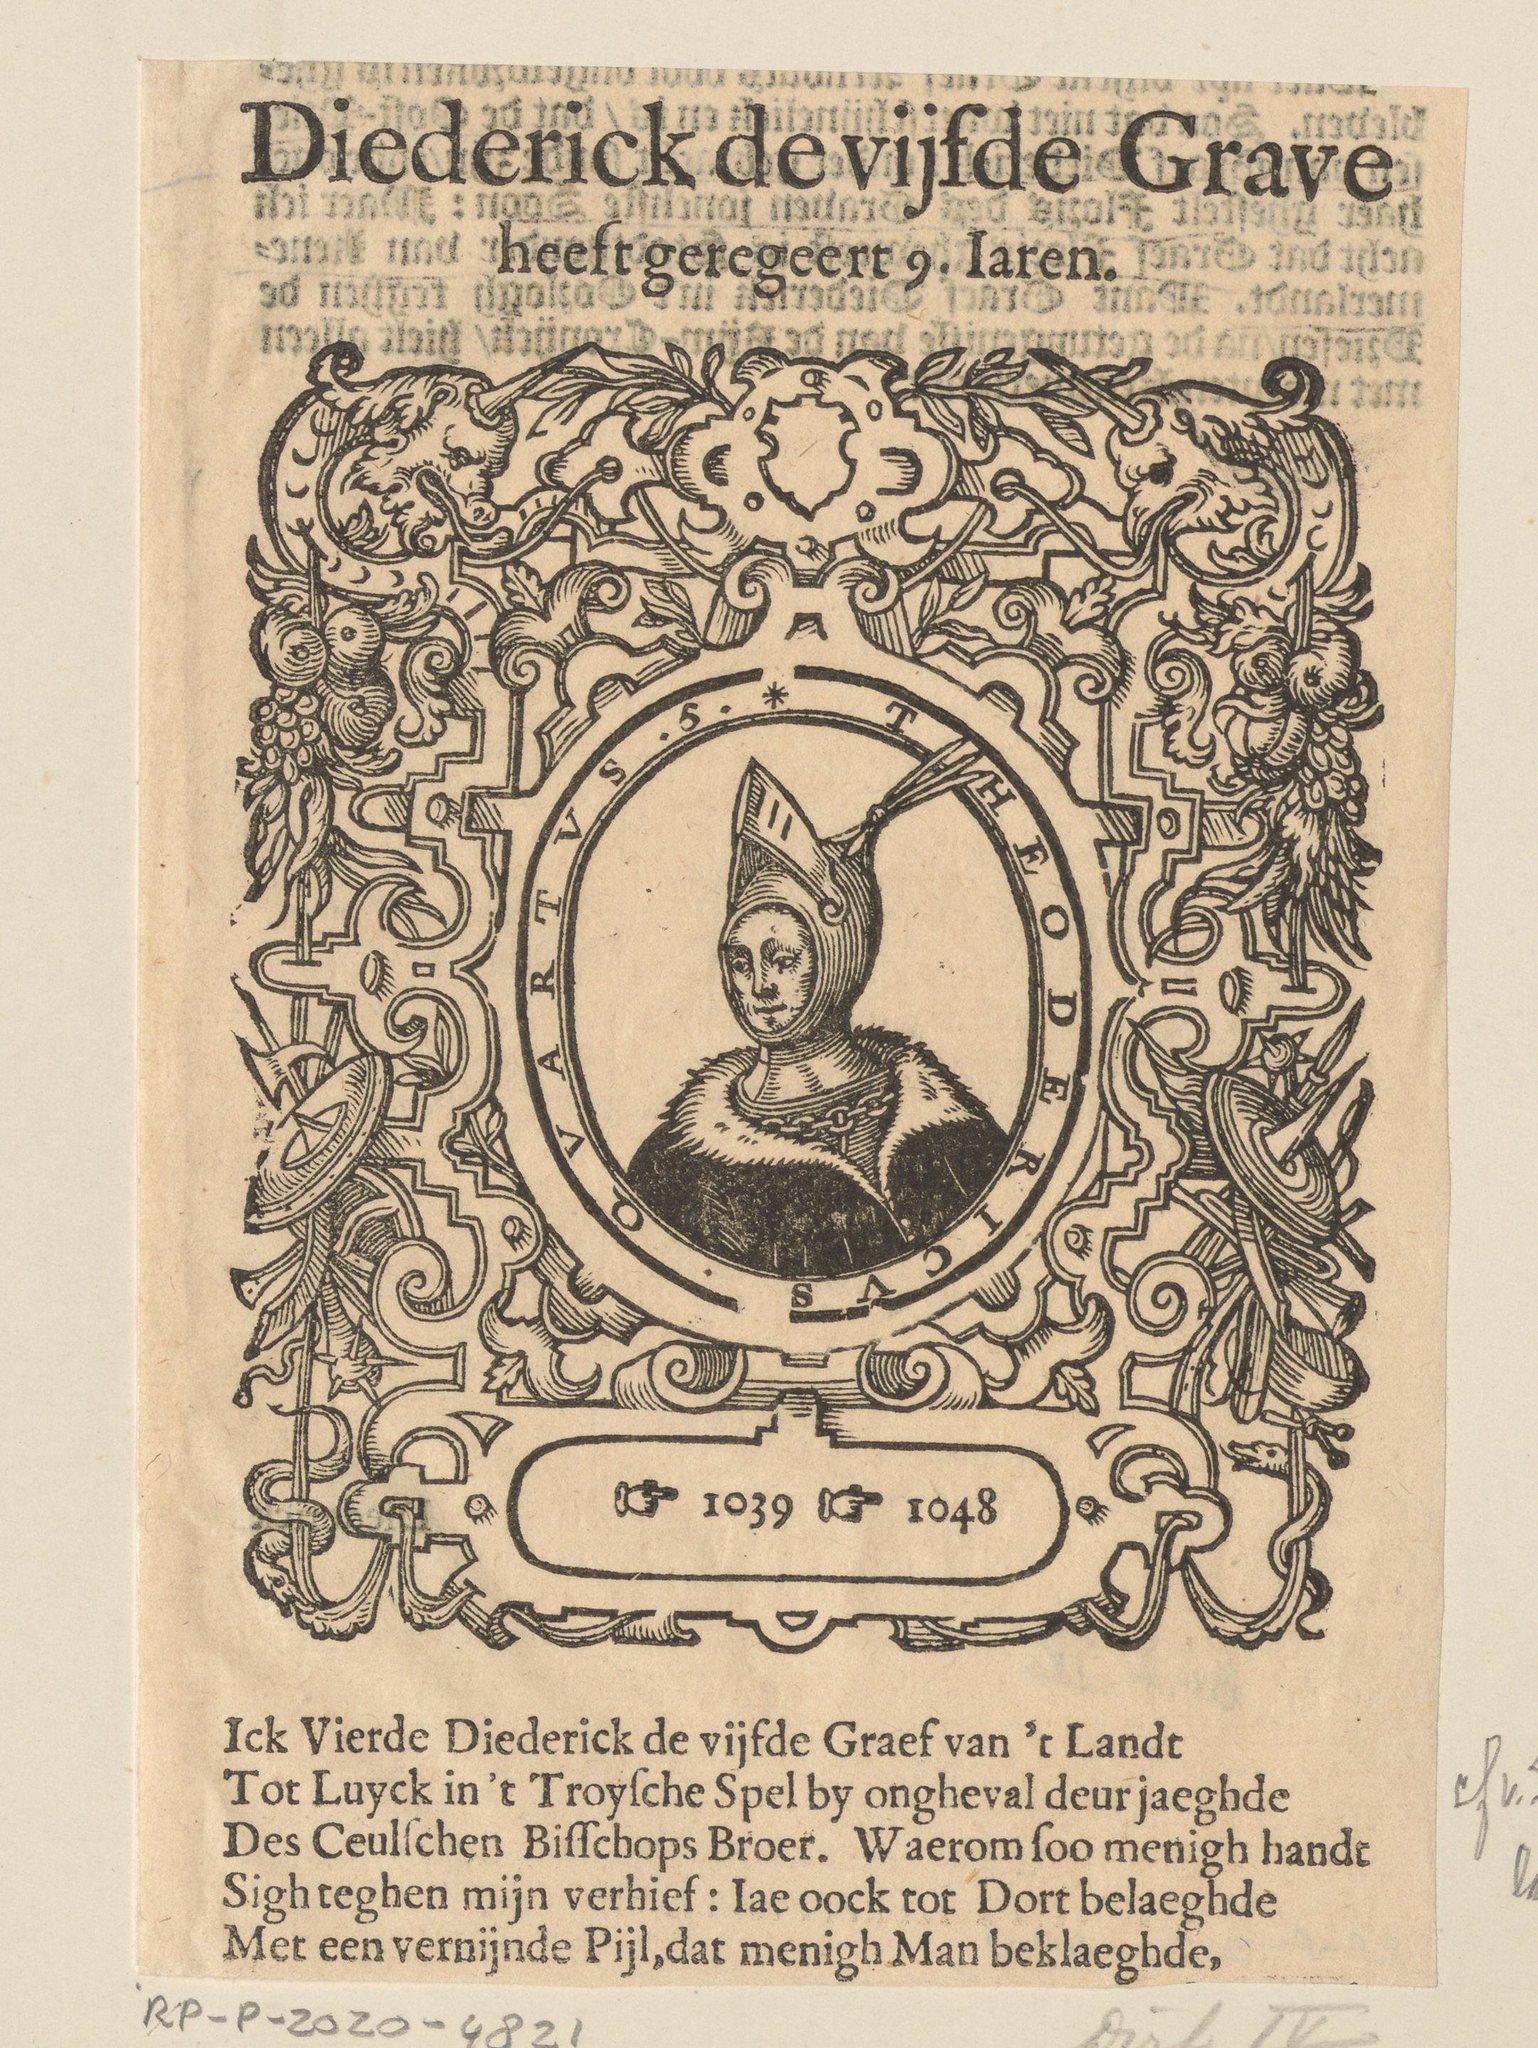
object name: book illustration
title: Portret van Dirk IV, graaf van Holland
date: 1636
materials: paper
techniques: letterpress printing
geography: amsterdam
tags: helmet, historical persons, ruler, sovereign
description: Prent uit: Scriverius, Petrus. Beschrivinge van out Batavien met de antiquiteyten vandien (...). Amsterdam: Jan Evertsz Cloppenburgh, 1636, p. 98.